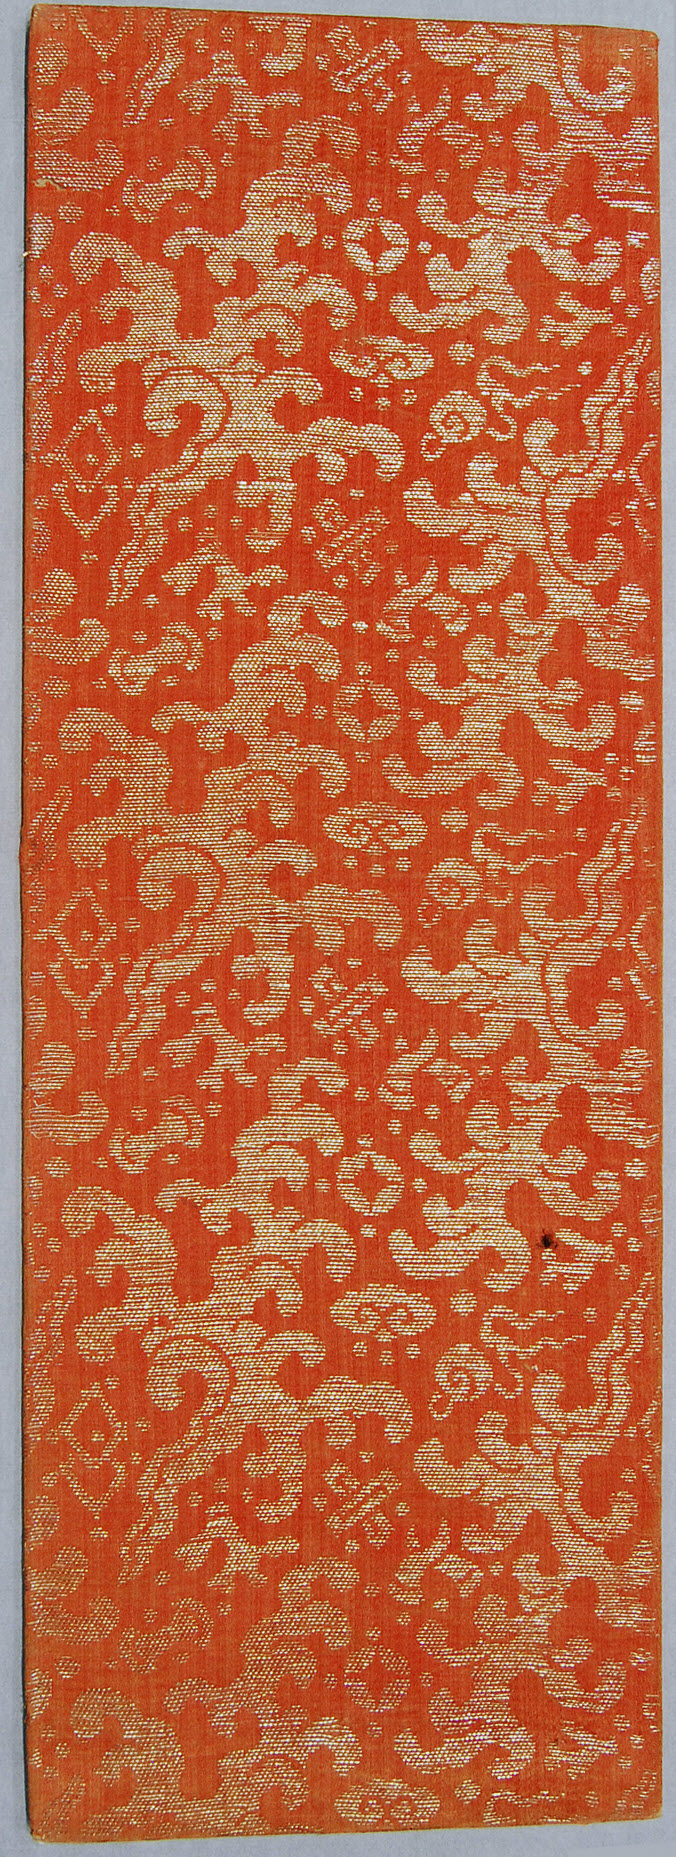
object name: sutra cover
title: Sutra Cover with Wavelike Clouds and Auspicious Symbols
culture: chinese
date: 1501-1600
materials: metal thread, silk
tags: clouds